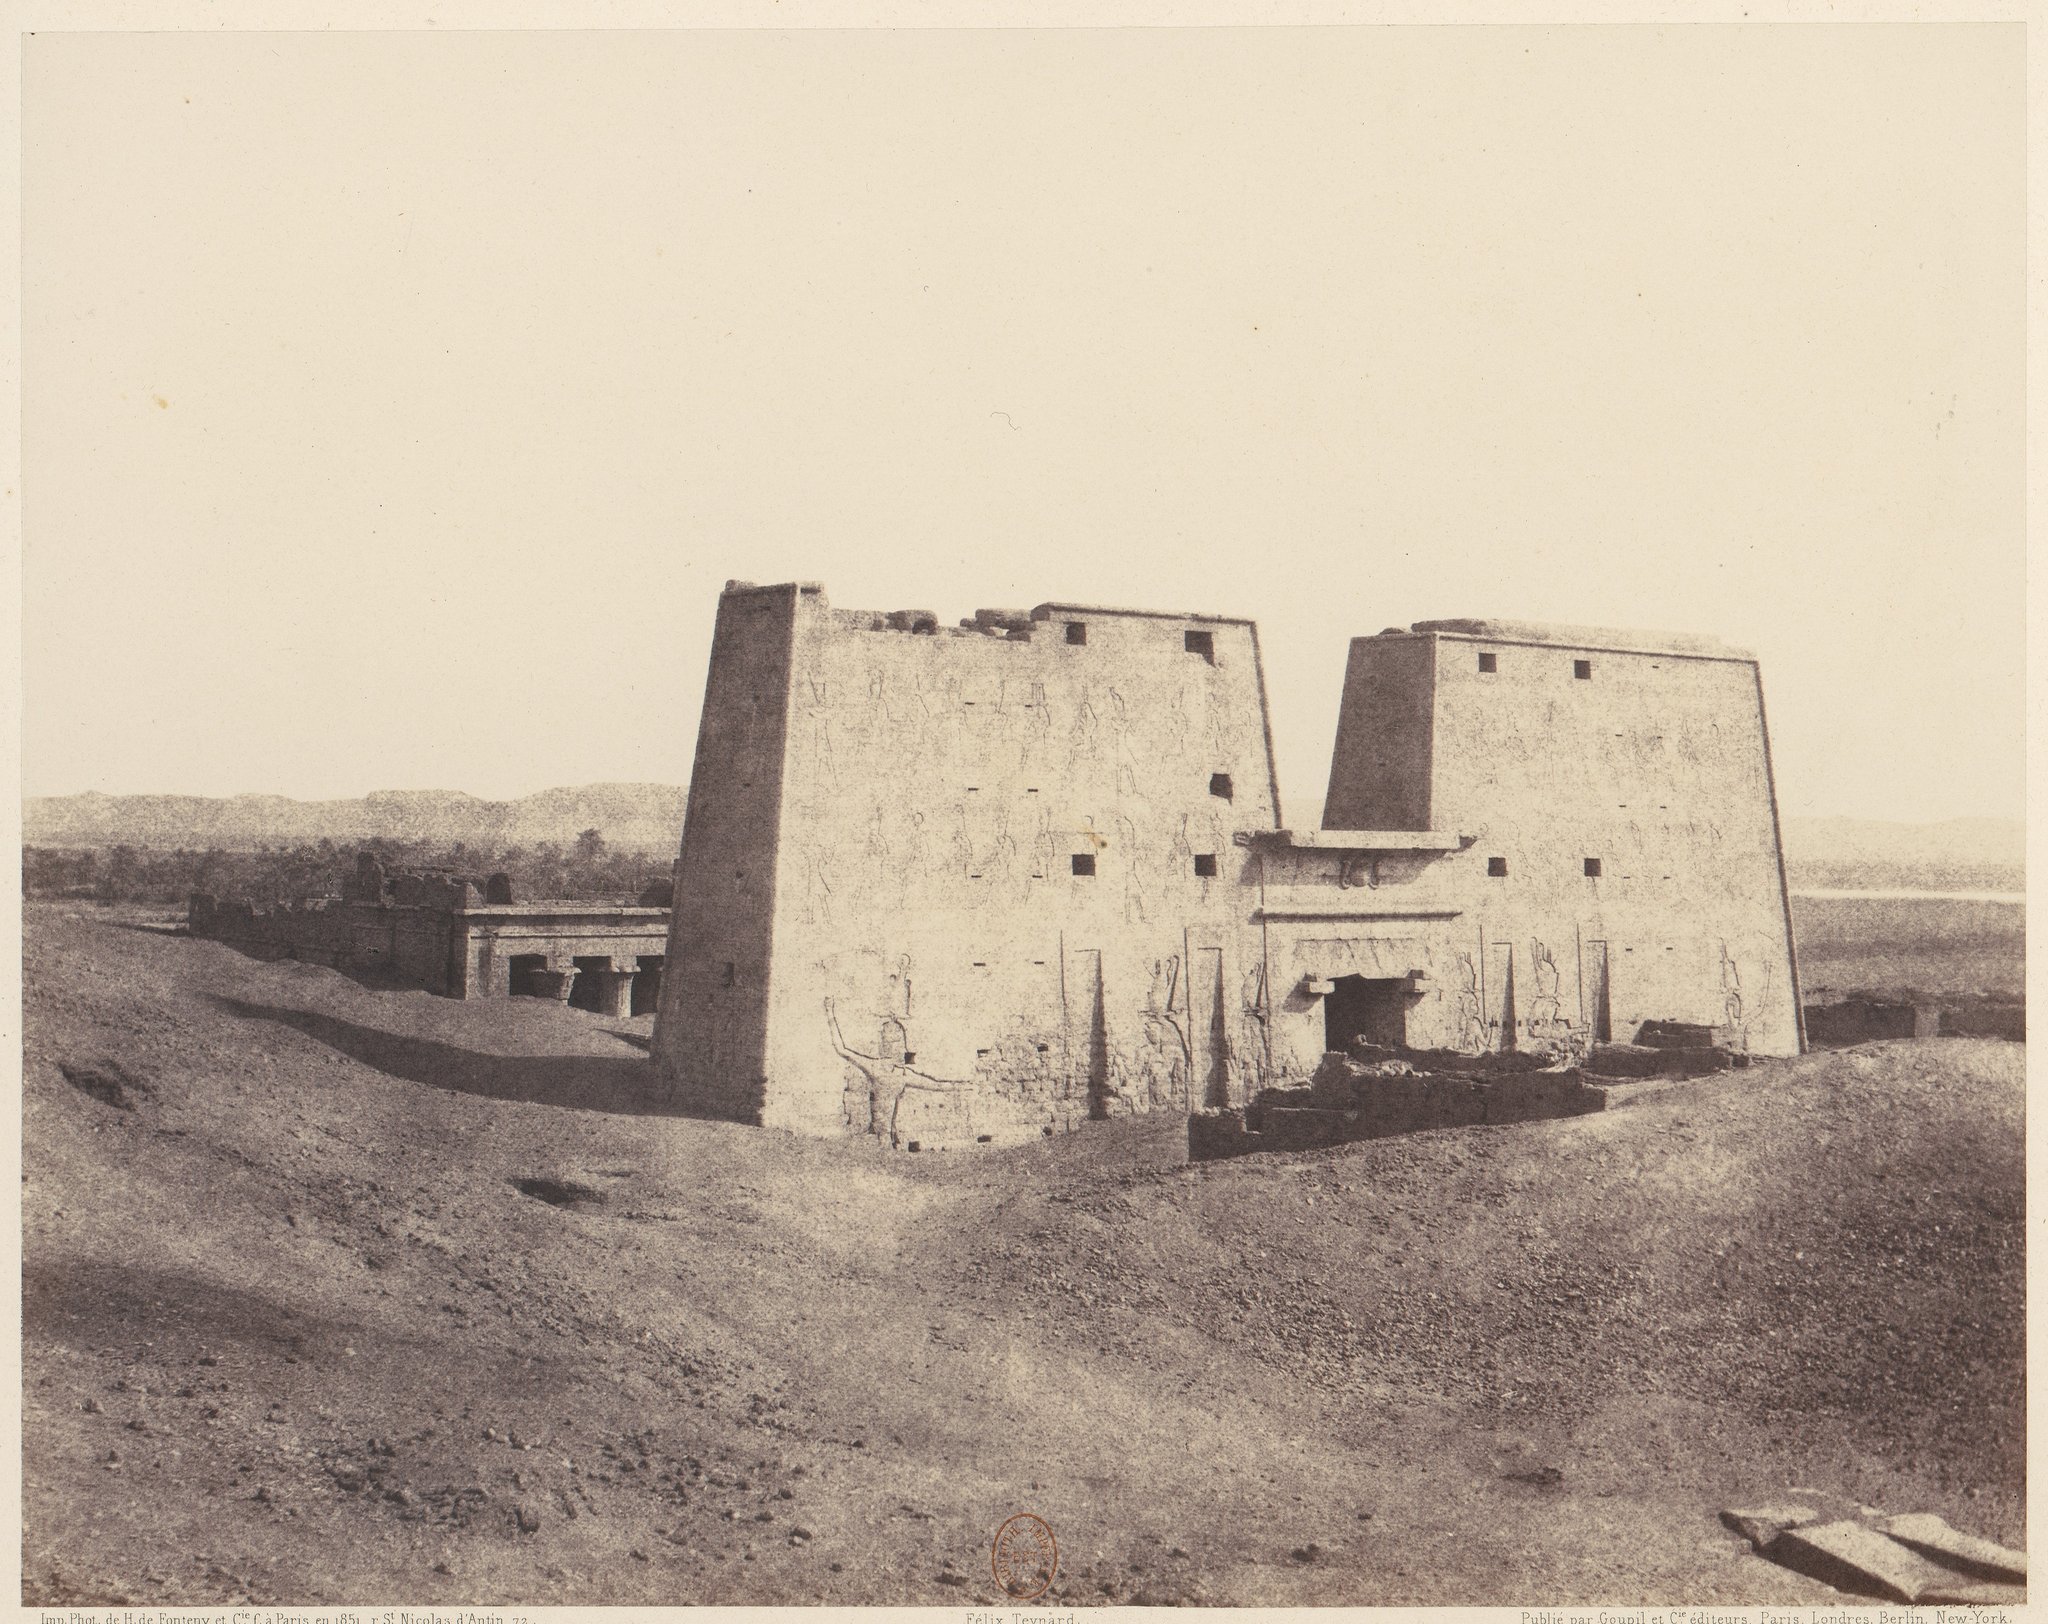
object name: photograph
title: Edfou (Apollonopolis Magna), Vue Générale du Temple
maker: félix teynard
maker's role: artist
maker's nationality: french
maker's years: 1817-1892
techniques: paper negative, salted paper print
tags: architecture,temples,ruins